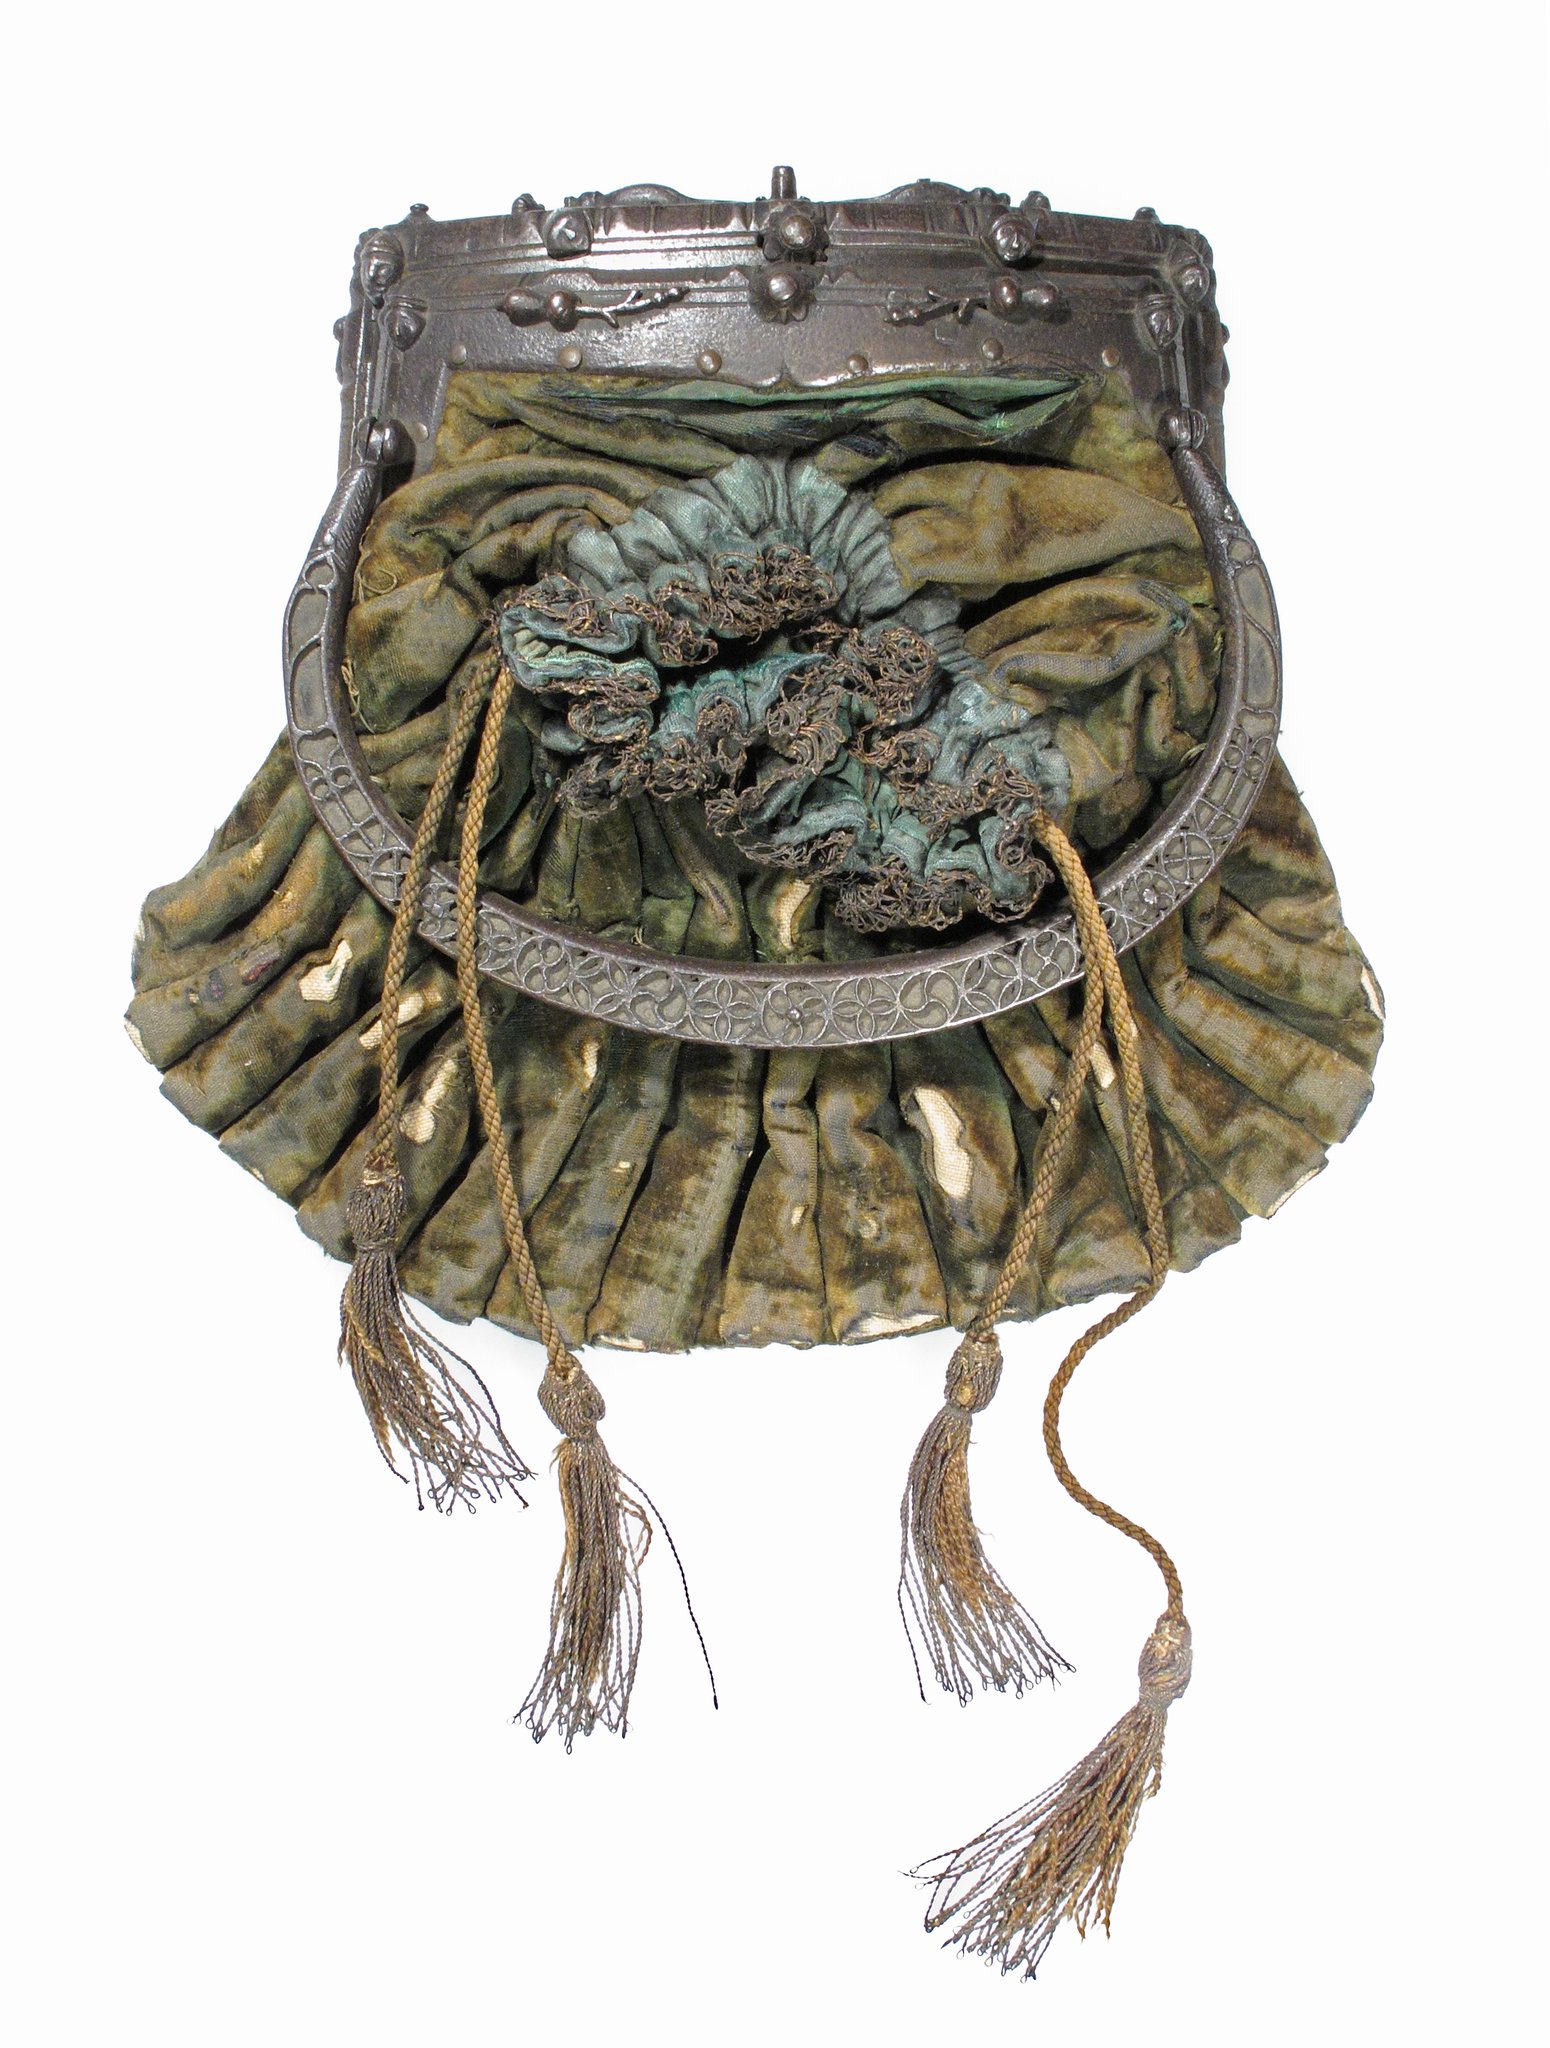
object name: game bag with iron mount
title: Bag for Game with Iron Mounts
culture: european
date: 1401-1600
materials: iron, silk, velvet